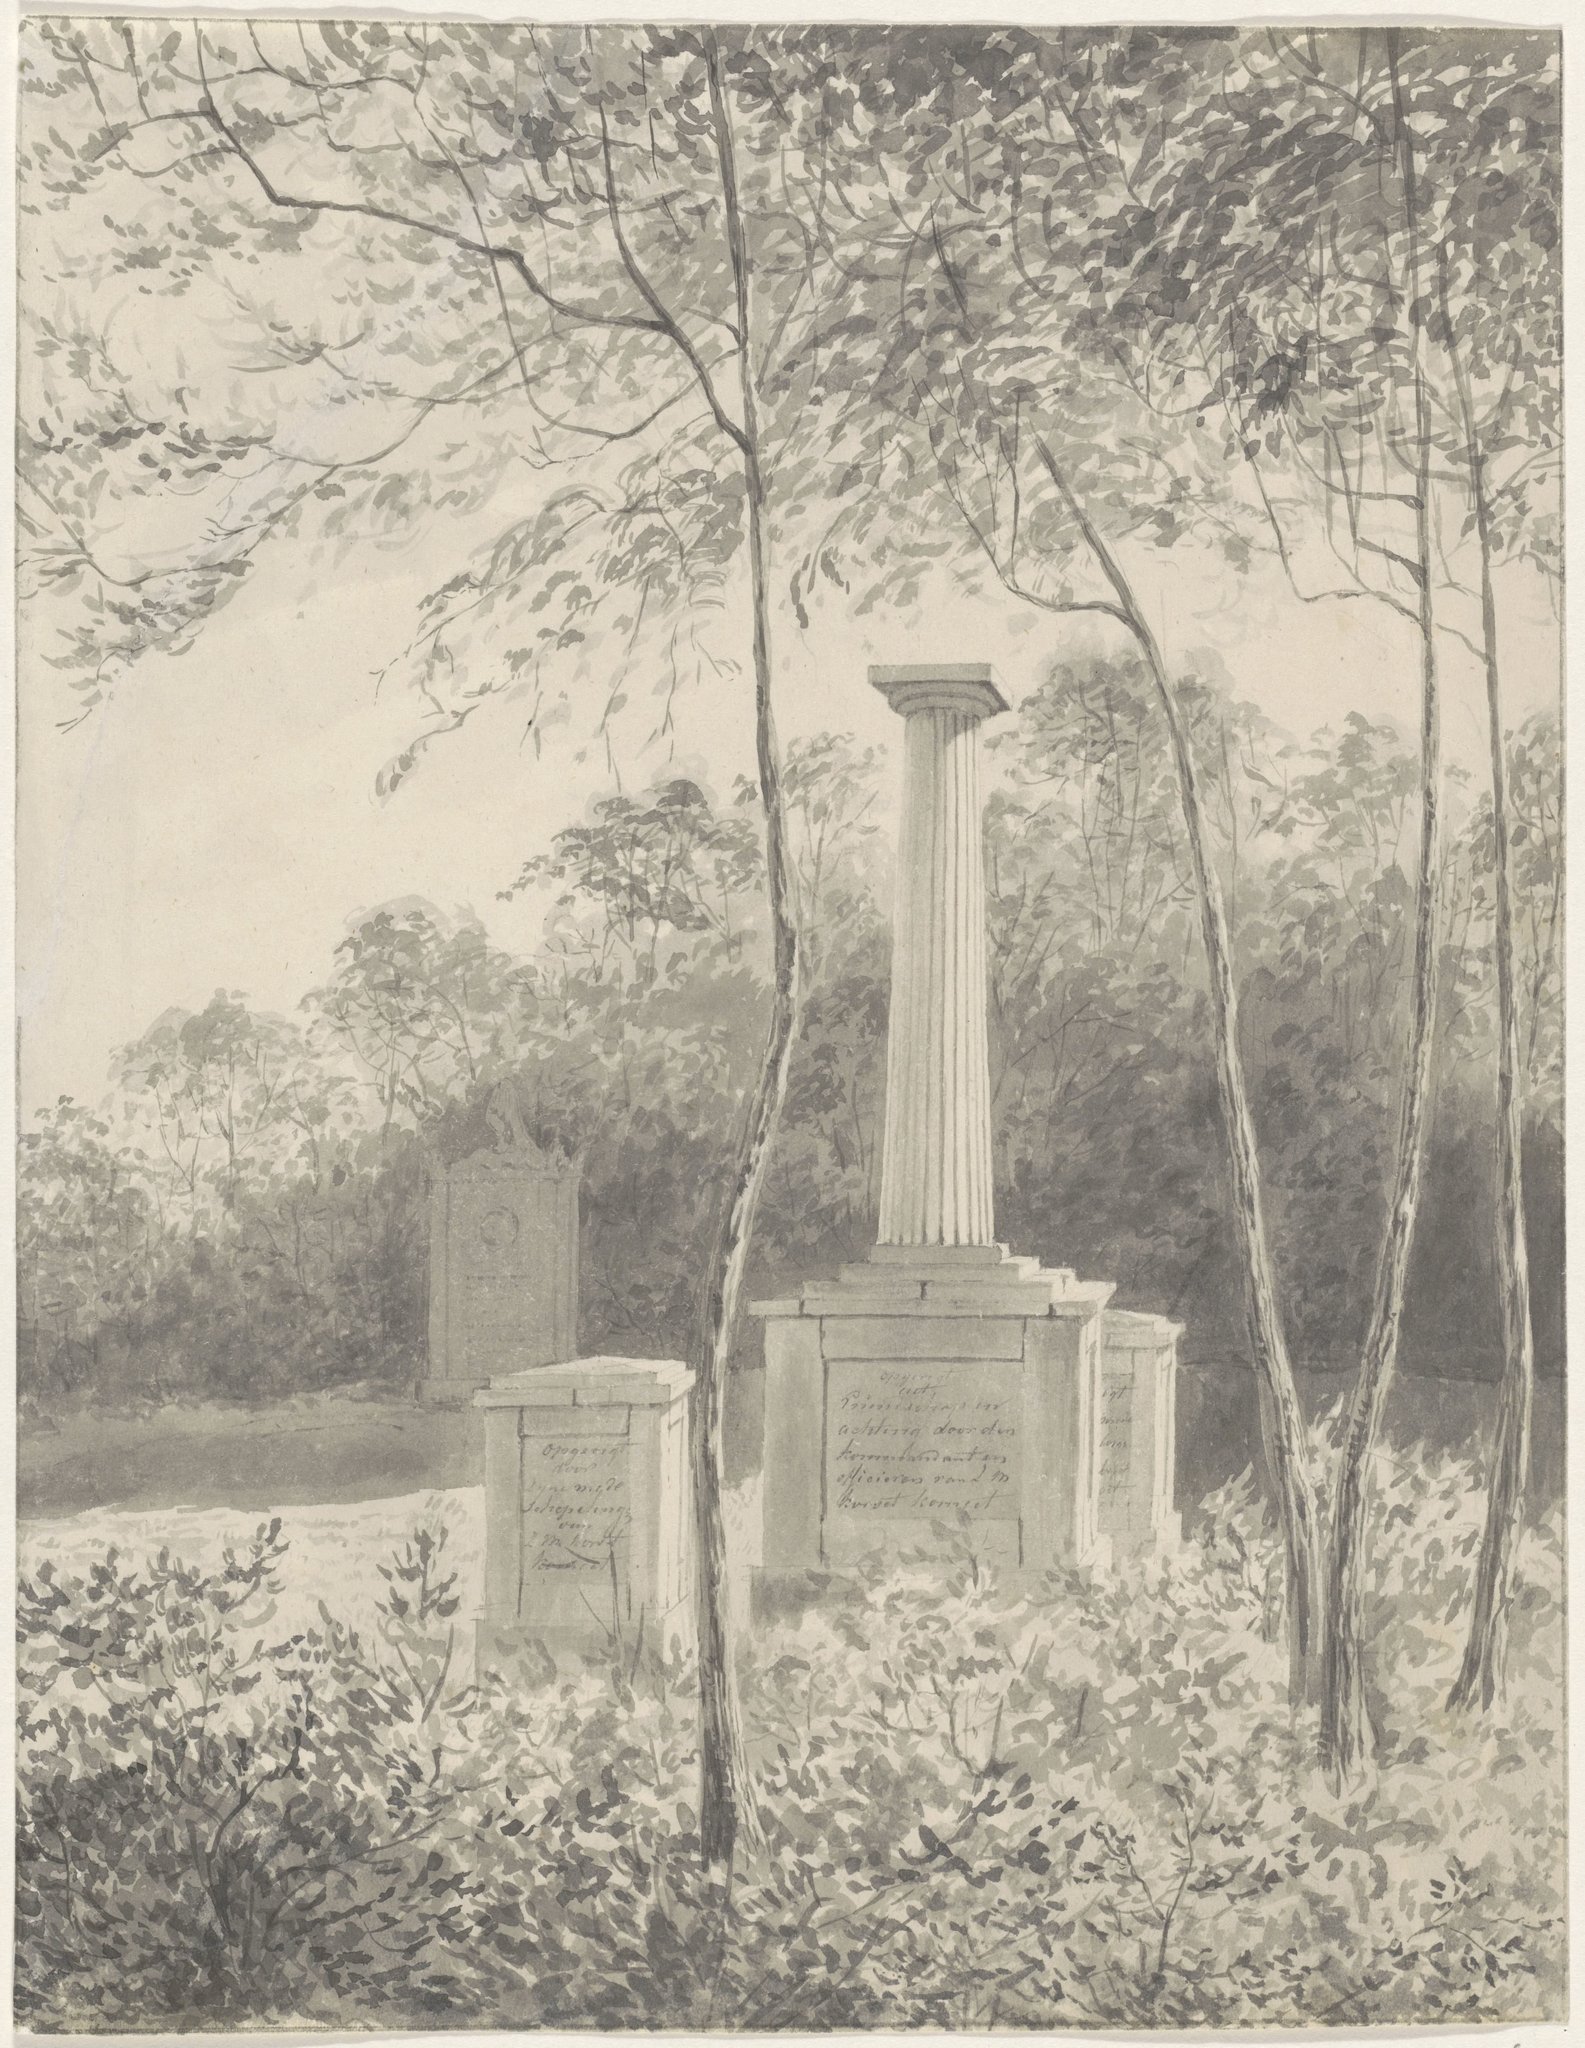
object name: drawing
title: Grafmonumenten voor Klinkhamer, Kreijenburg en Hartz, 1830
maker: Anonymous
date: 1830-1831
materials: paper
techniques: brush, pen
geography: netherlands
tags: amsterdam, grave, tomb, flushing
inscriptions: collector's mark: Lugt 2228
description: Kerkhof te Vlissingen met de drie grafmonumenten voor Justus Klinkhamer, Johannes Clemz. Kreijenburg (of Kryenburg) en Peter Hartz. Allen Nederlandse militairen bij de marine gestorven tijdens of na het bombardement op Antwerpen op 27 oktober 1830. Het monument voor Klinkhamer in de vorm van een zuil op een voetstuk.